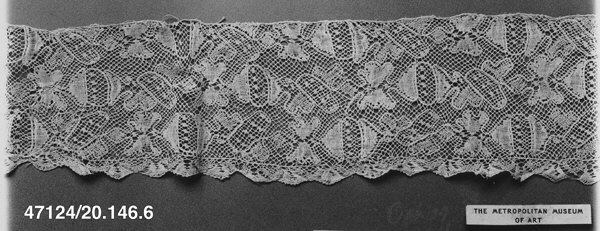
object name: fragment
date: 1701-1800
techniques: lace